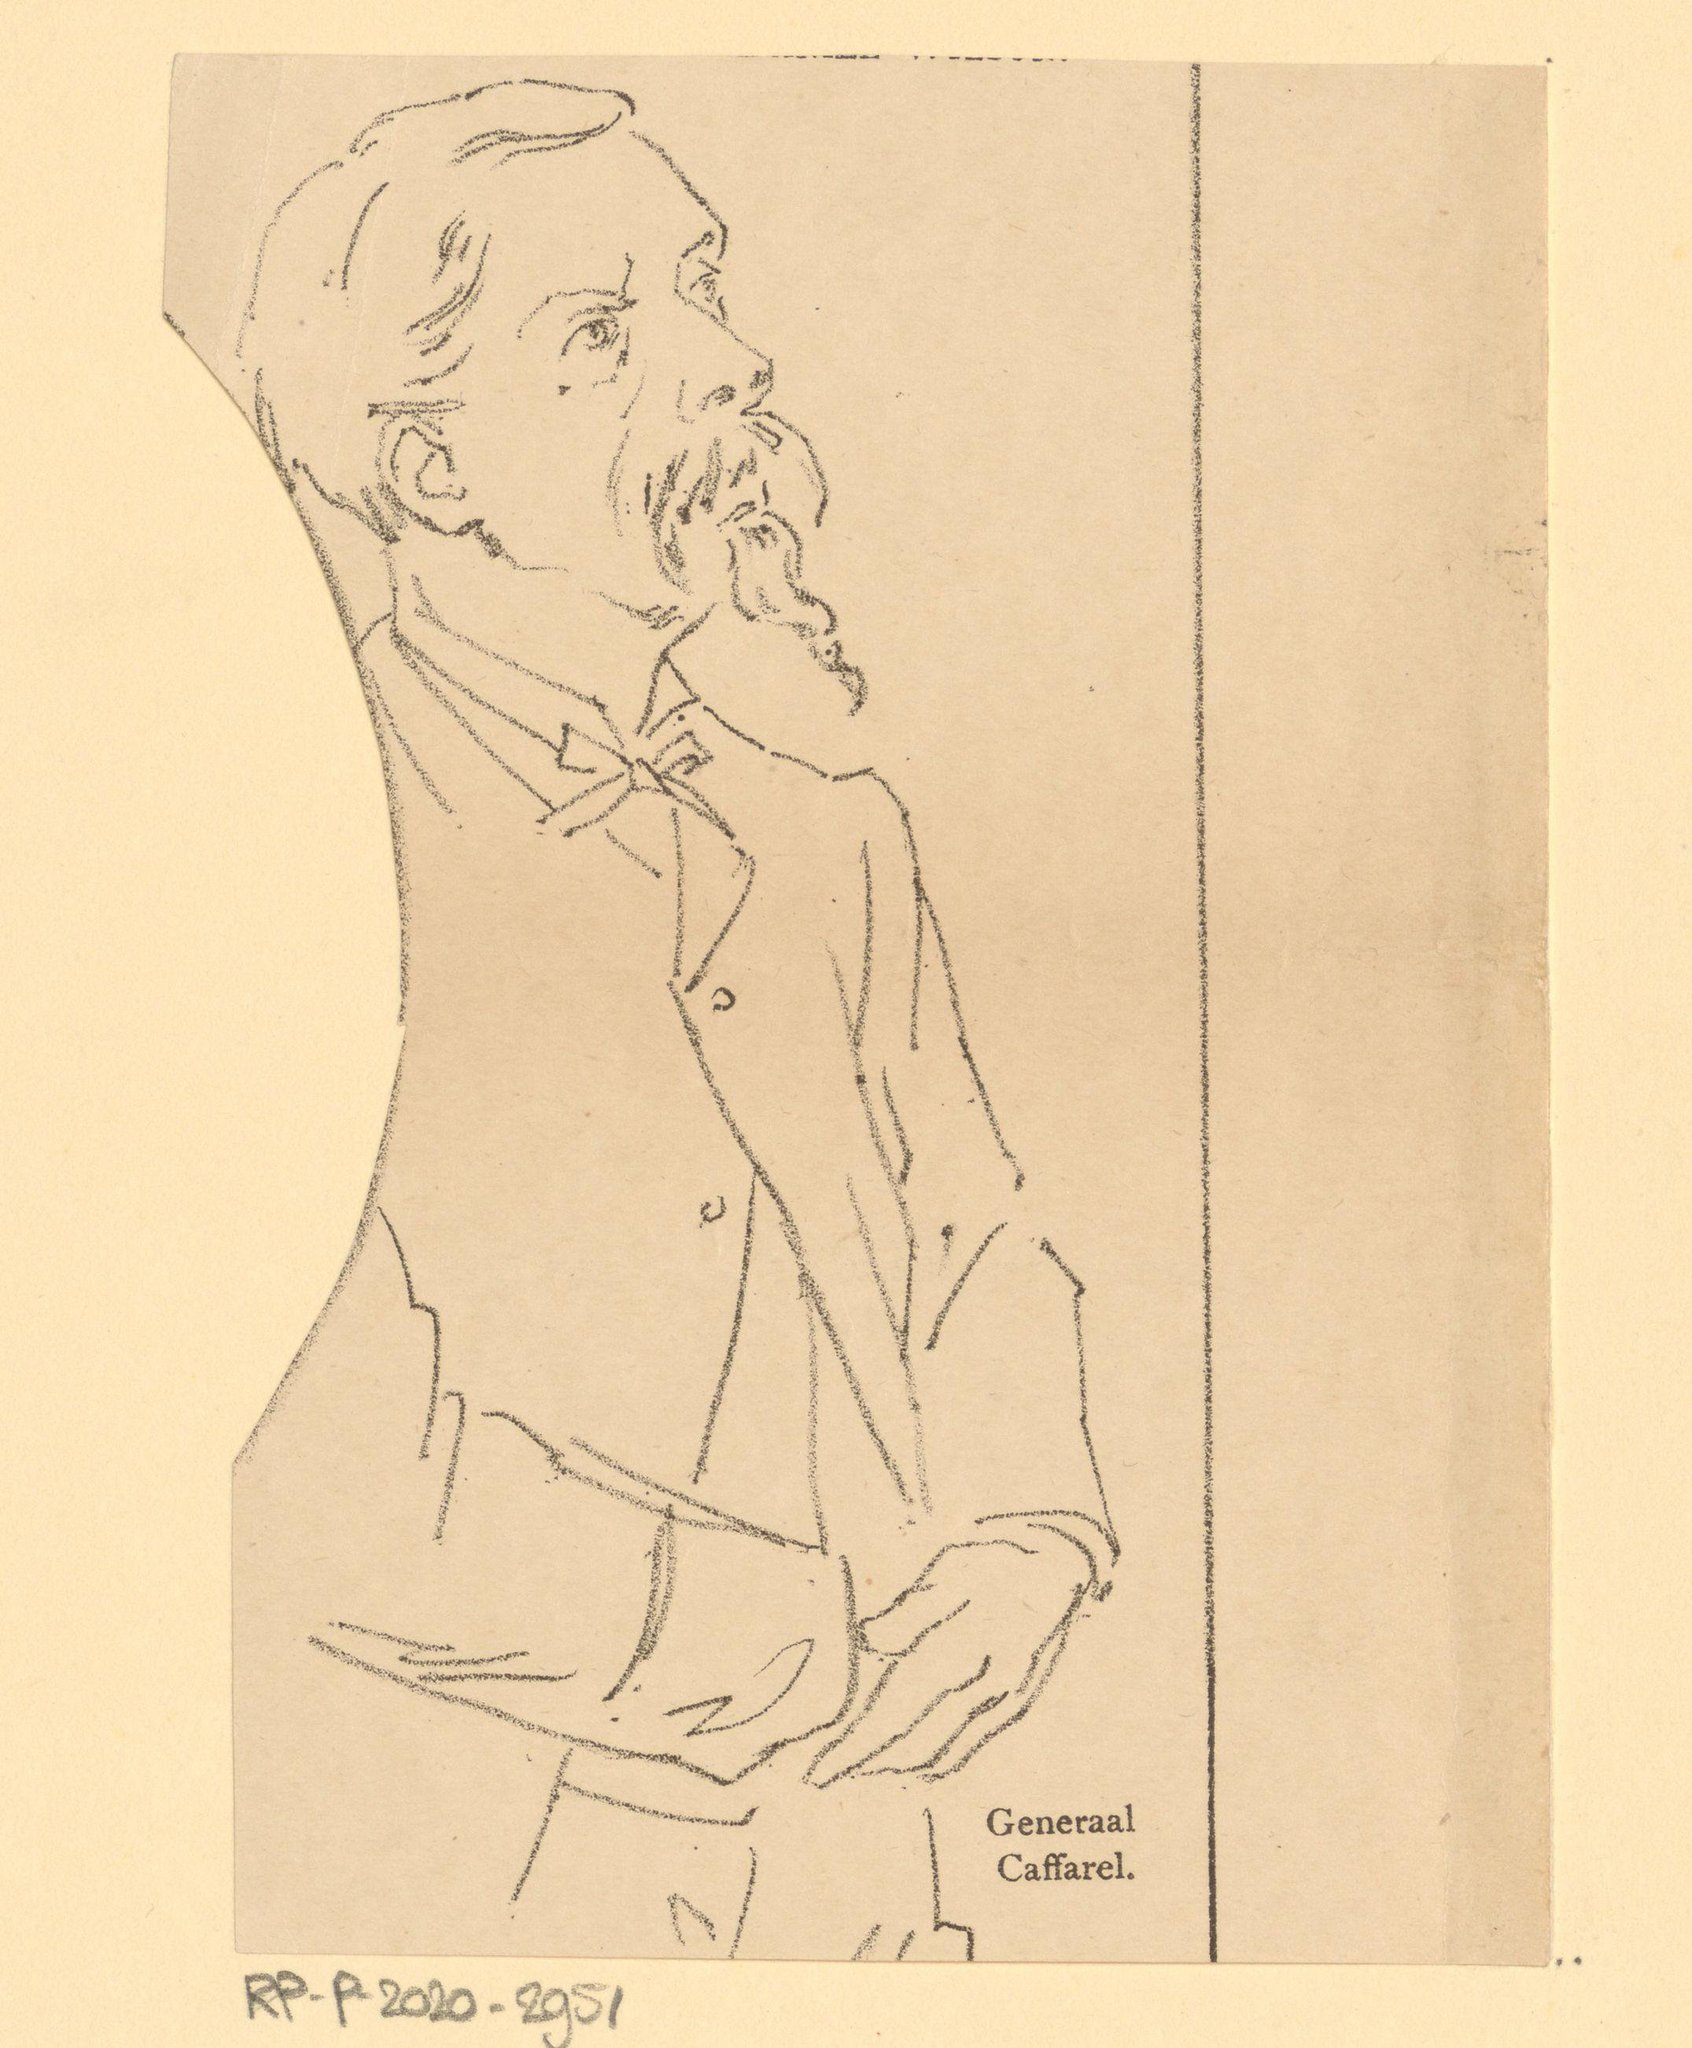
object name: print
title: Portret van generaal Caffarel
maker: Anonymous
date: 1887-1897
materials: paper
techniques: letterpress printing, lithograph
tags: commander-in-chief, general, marshal, historical persons